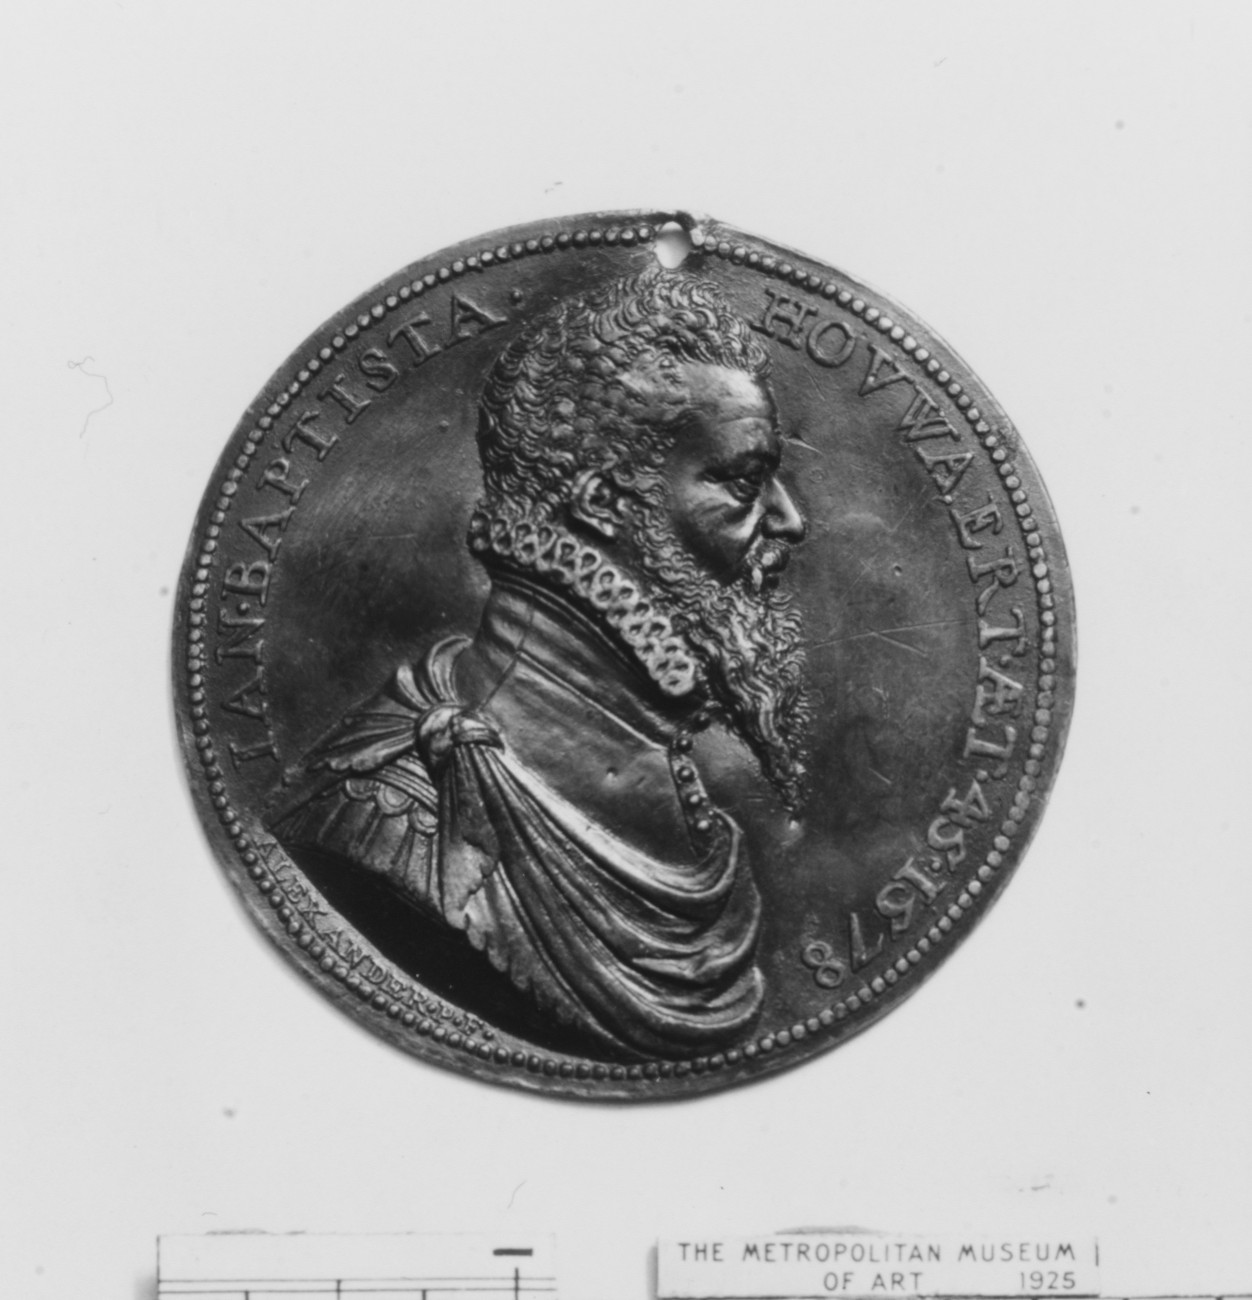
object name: medal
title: Jehan Baptiste Houwaert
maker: p. f. alexander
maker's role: artist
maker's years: 1520-1578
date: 1501-1600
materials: lead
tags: men,profiles